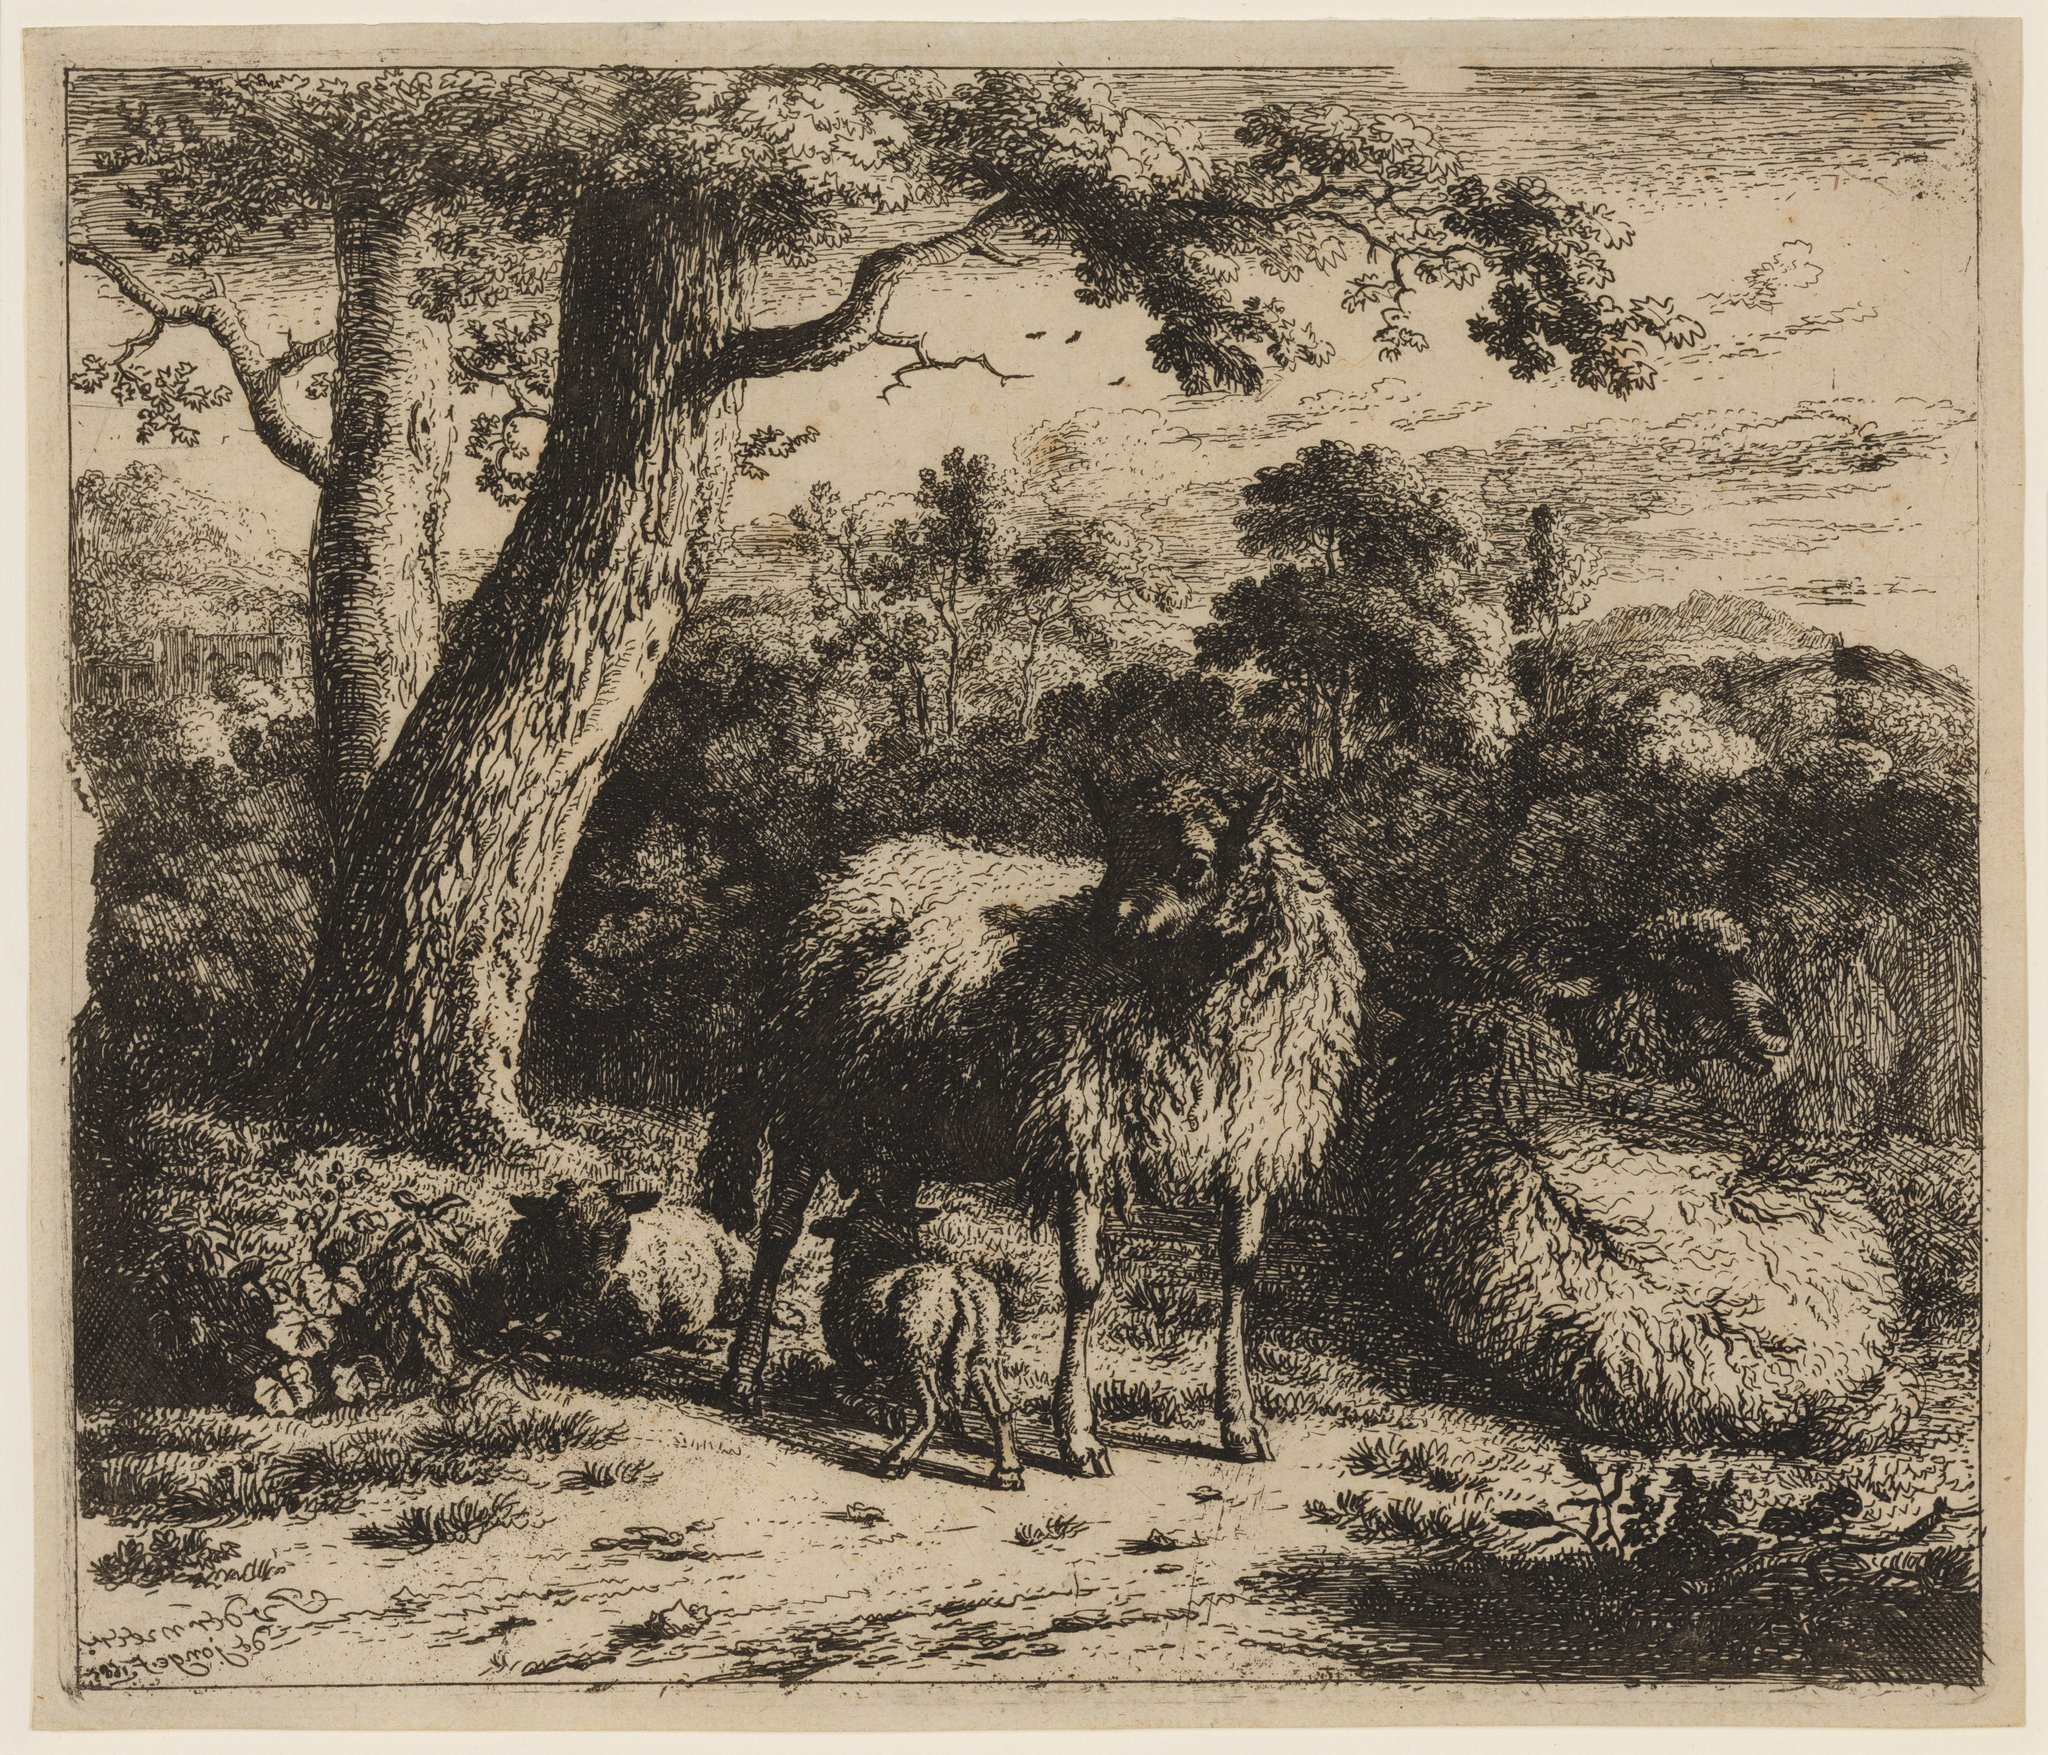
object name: print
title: The Standing Sheep with Two Lambkins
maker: jan van der meer the younger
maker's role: artist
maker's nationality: dutch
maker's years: 1656-1705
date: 1682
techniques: etching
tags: sheep